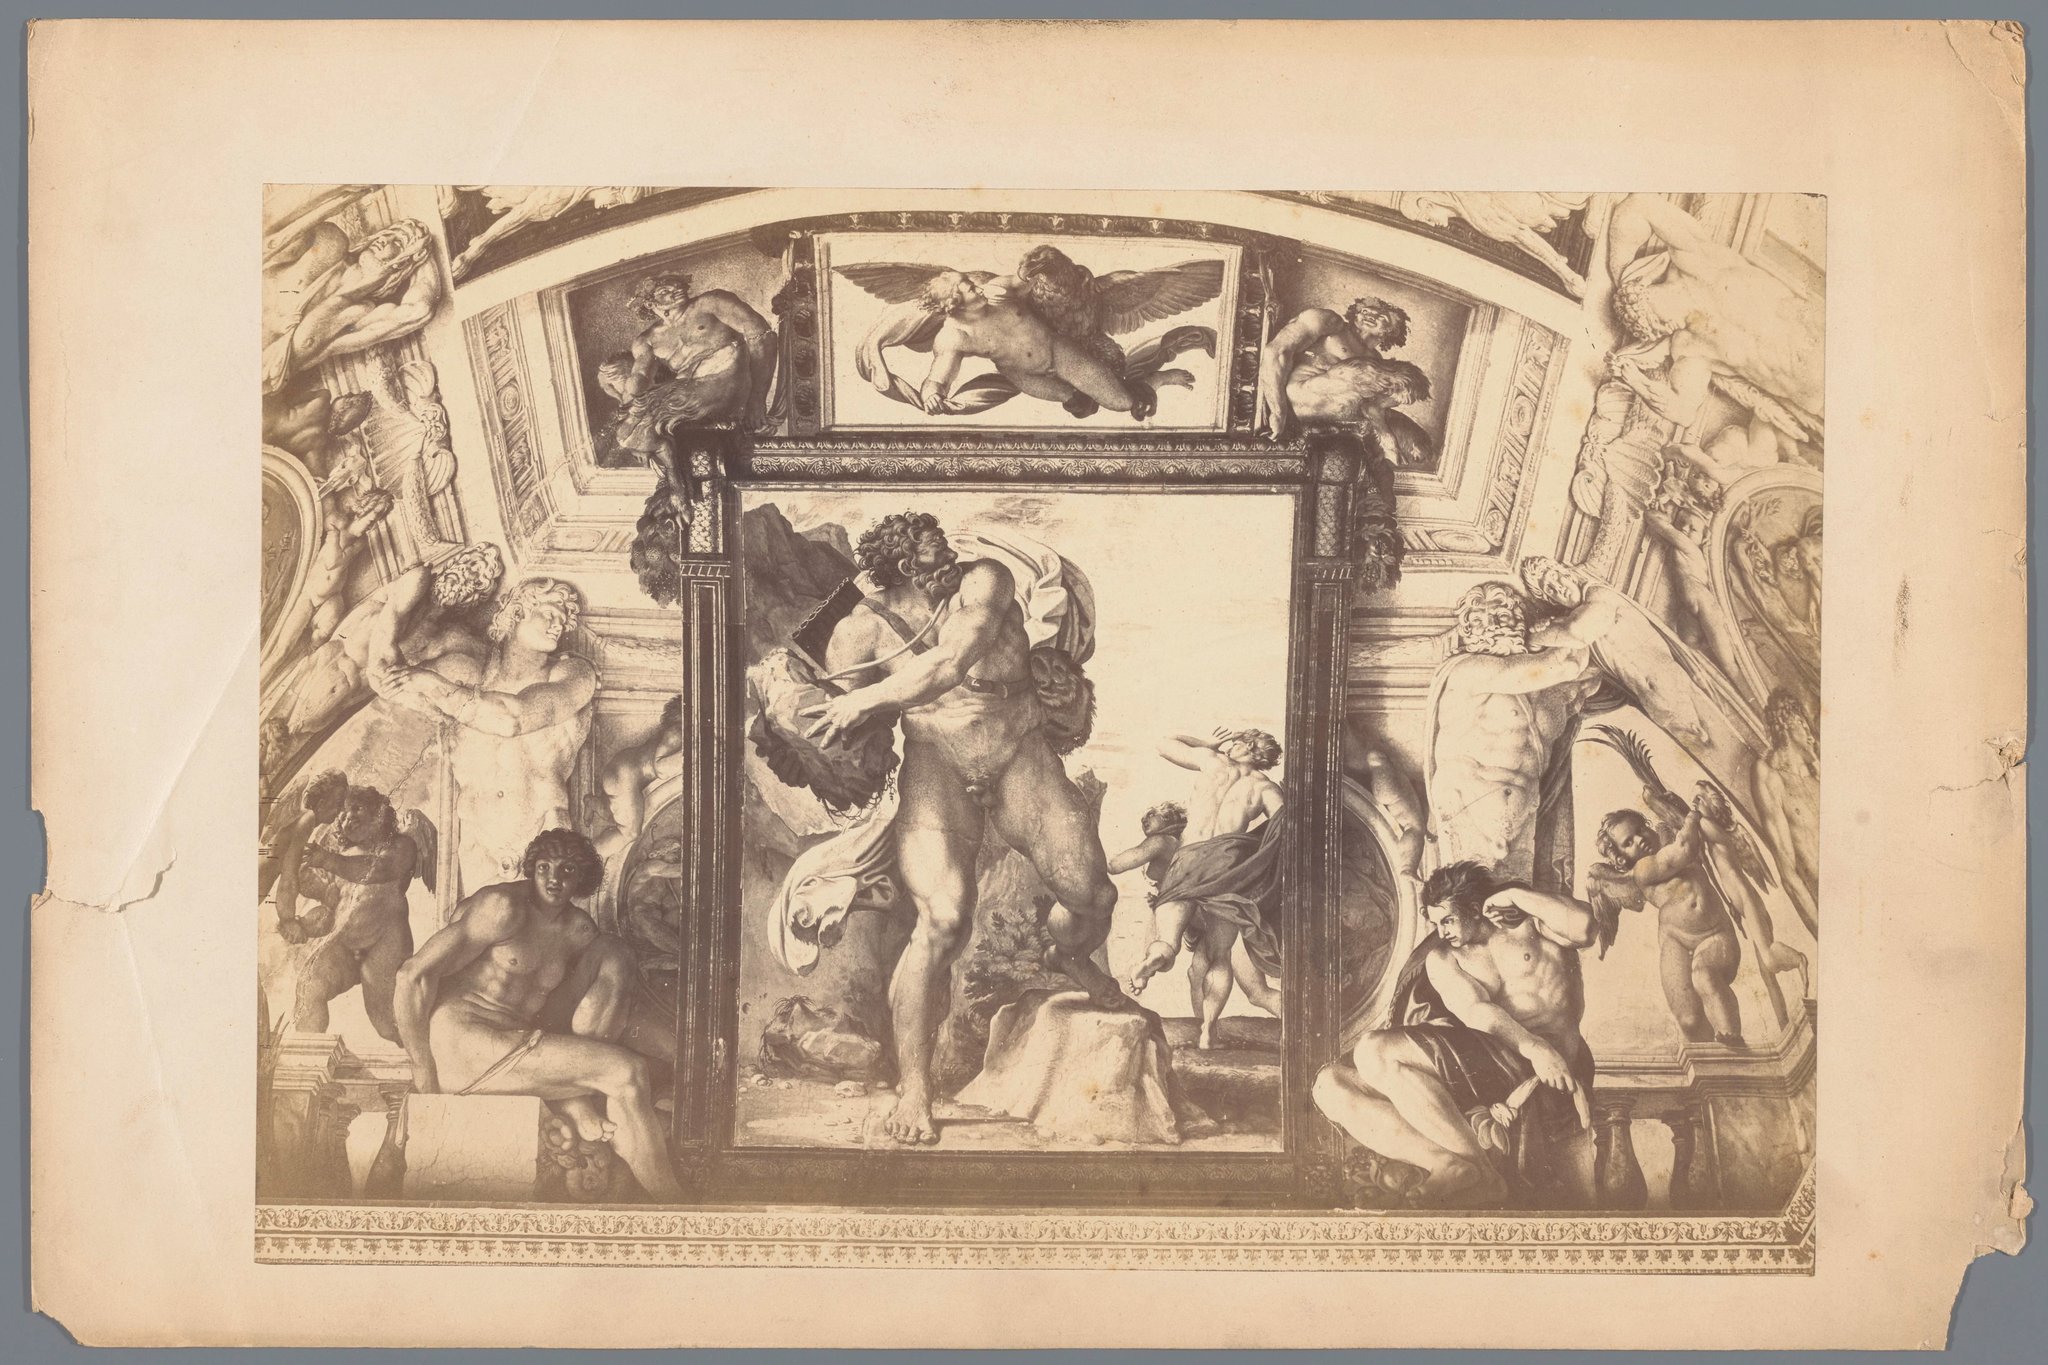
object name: reproduction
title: Fotoreproductie van een deel van de fresco's in het Palazzo Farnese door Annibale Carracci, voorstellende Polyphemos die Acis en Galatea aanvalt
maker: Anonymous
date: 1875-1900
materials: cardboard, photographic support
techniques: albumen print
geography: palazzo farnese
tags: sitting figure, atlantes ~ architecture, the rape of ganymede: he is carried off through the air by jupiter in the form of an eagle, or by the eagle of jupiter, acis and galatea flee from polyphemus, who seizes a rock to crush acis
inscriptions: collector's mark: Lugt 3937